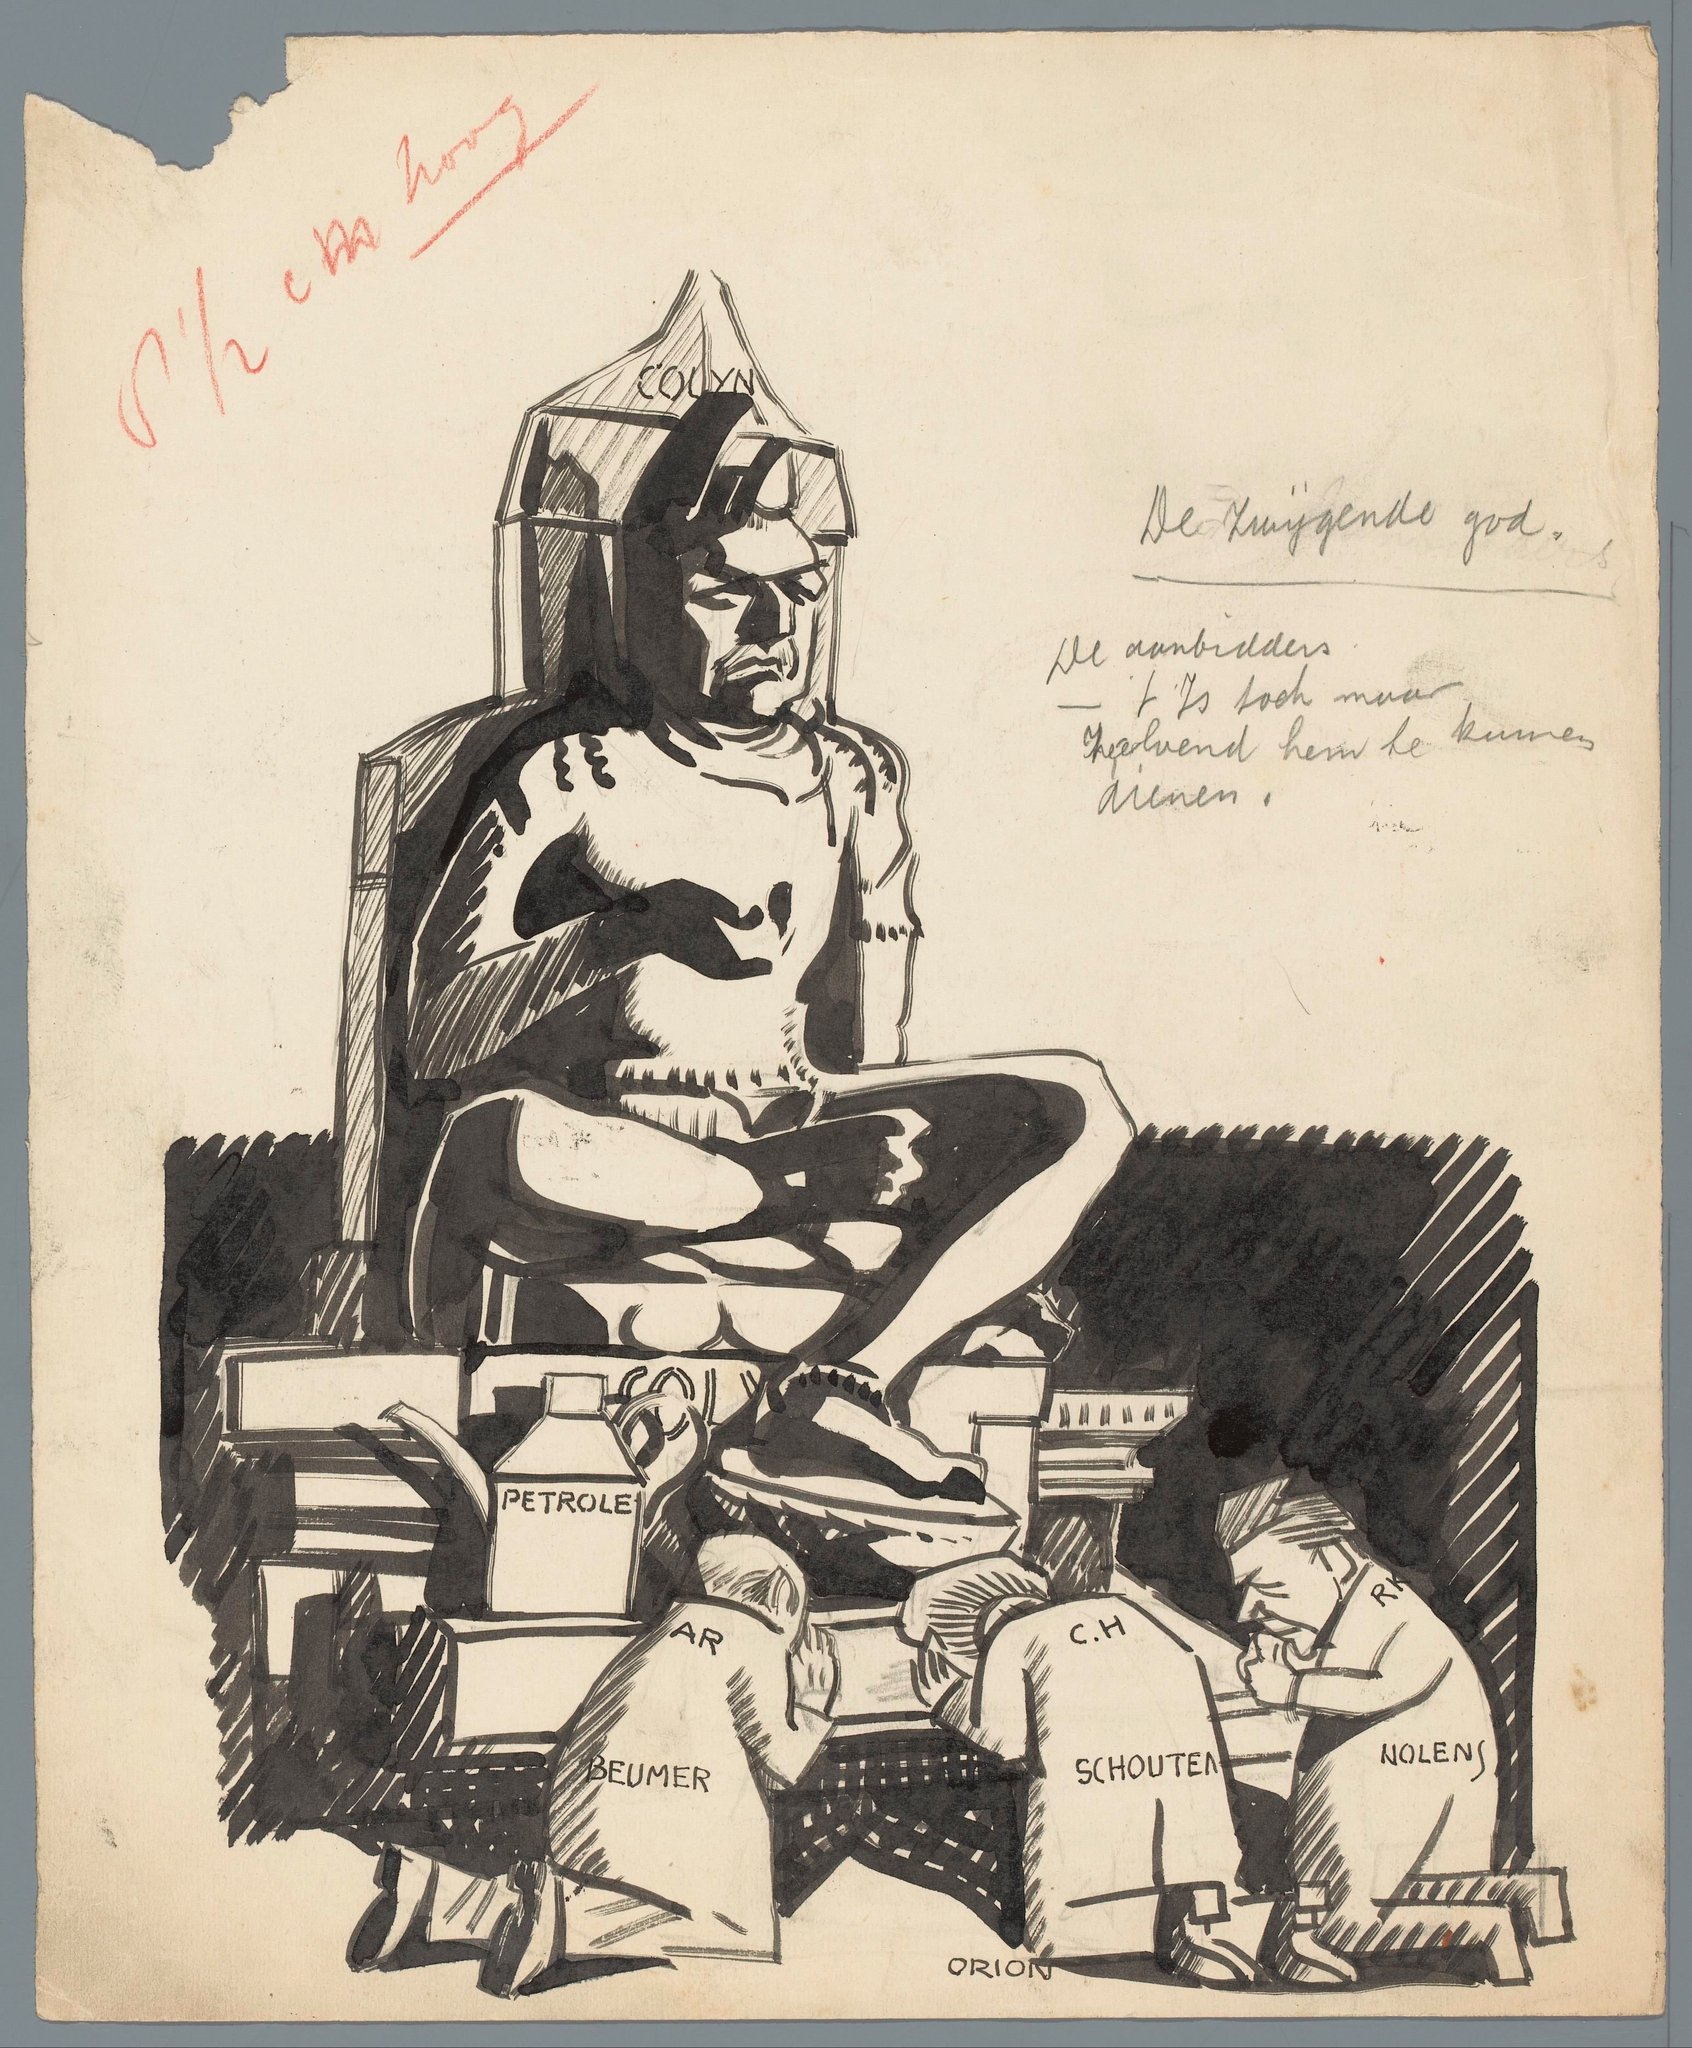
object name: drawing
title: Colijn als een Oosterse god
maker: patricq kroon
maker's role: draughtsman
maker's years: 1862-1941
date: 1920-1935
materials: ink, paper, pencil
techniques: brush, pen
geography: netherlands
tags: priest, hendrikus colijn, political parties, political caricatures and satires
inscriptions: inscription: ‘De zwijgende god/ / De aanbidders - t Is toch maar zalvend hem te kunnen dienen.’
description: De drie christelijke partijen (Beumer, Schouten, Nolens) knielen voor een standbeeld van Colijn als een boos kijkende Oosterse god. Aan de voet van het beeld staat een kan petroleum. Ontwerp voor een politieke spotprent.